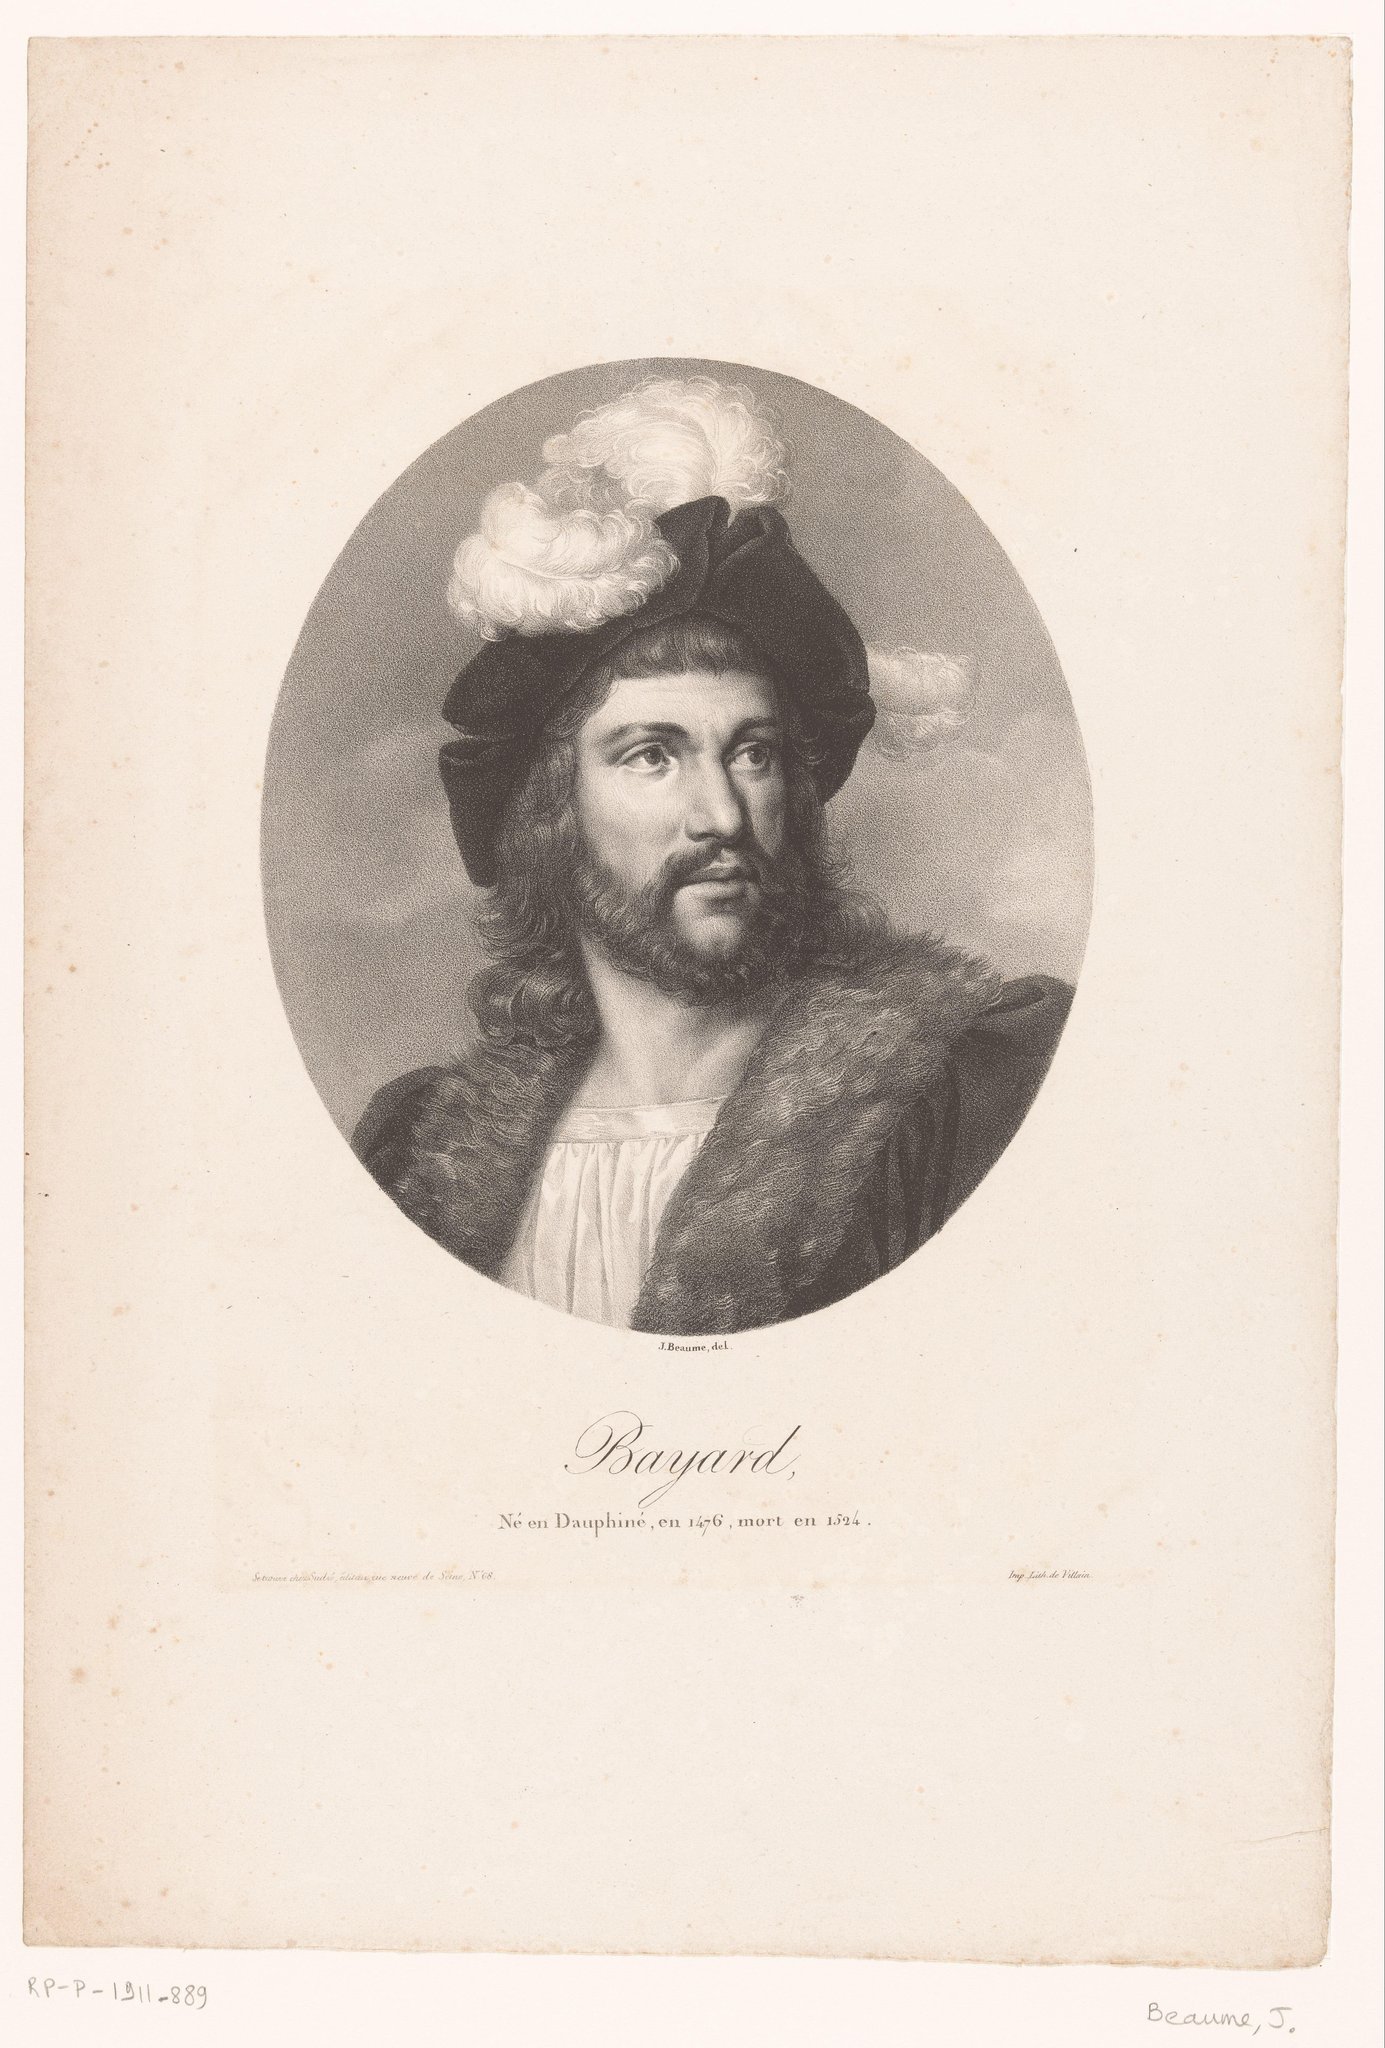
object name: print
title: Portretten van Franse beroemdheden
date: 1823-1827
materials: paper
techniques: lithograph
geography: paris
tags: pierre du terrail de bayard, historical persons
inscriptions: collector's mark: Lugt 2228a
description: De serie is in verschillende livrasons uitgegeven door Pierre Sudré tussen 1823 en 1827.